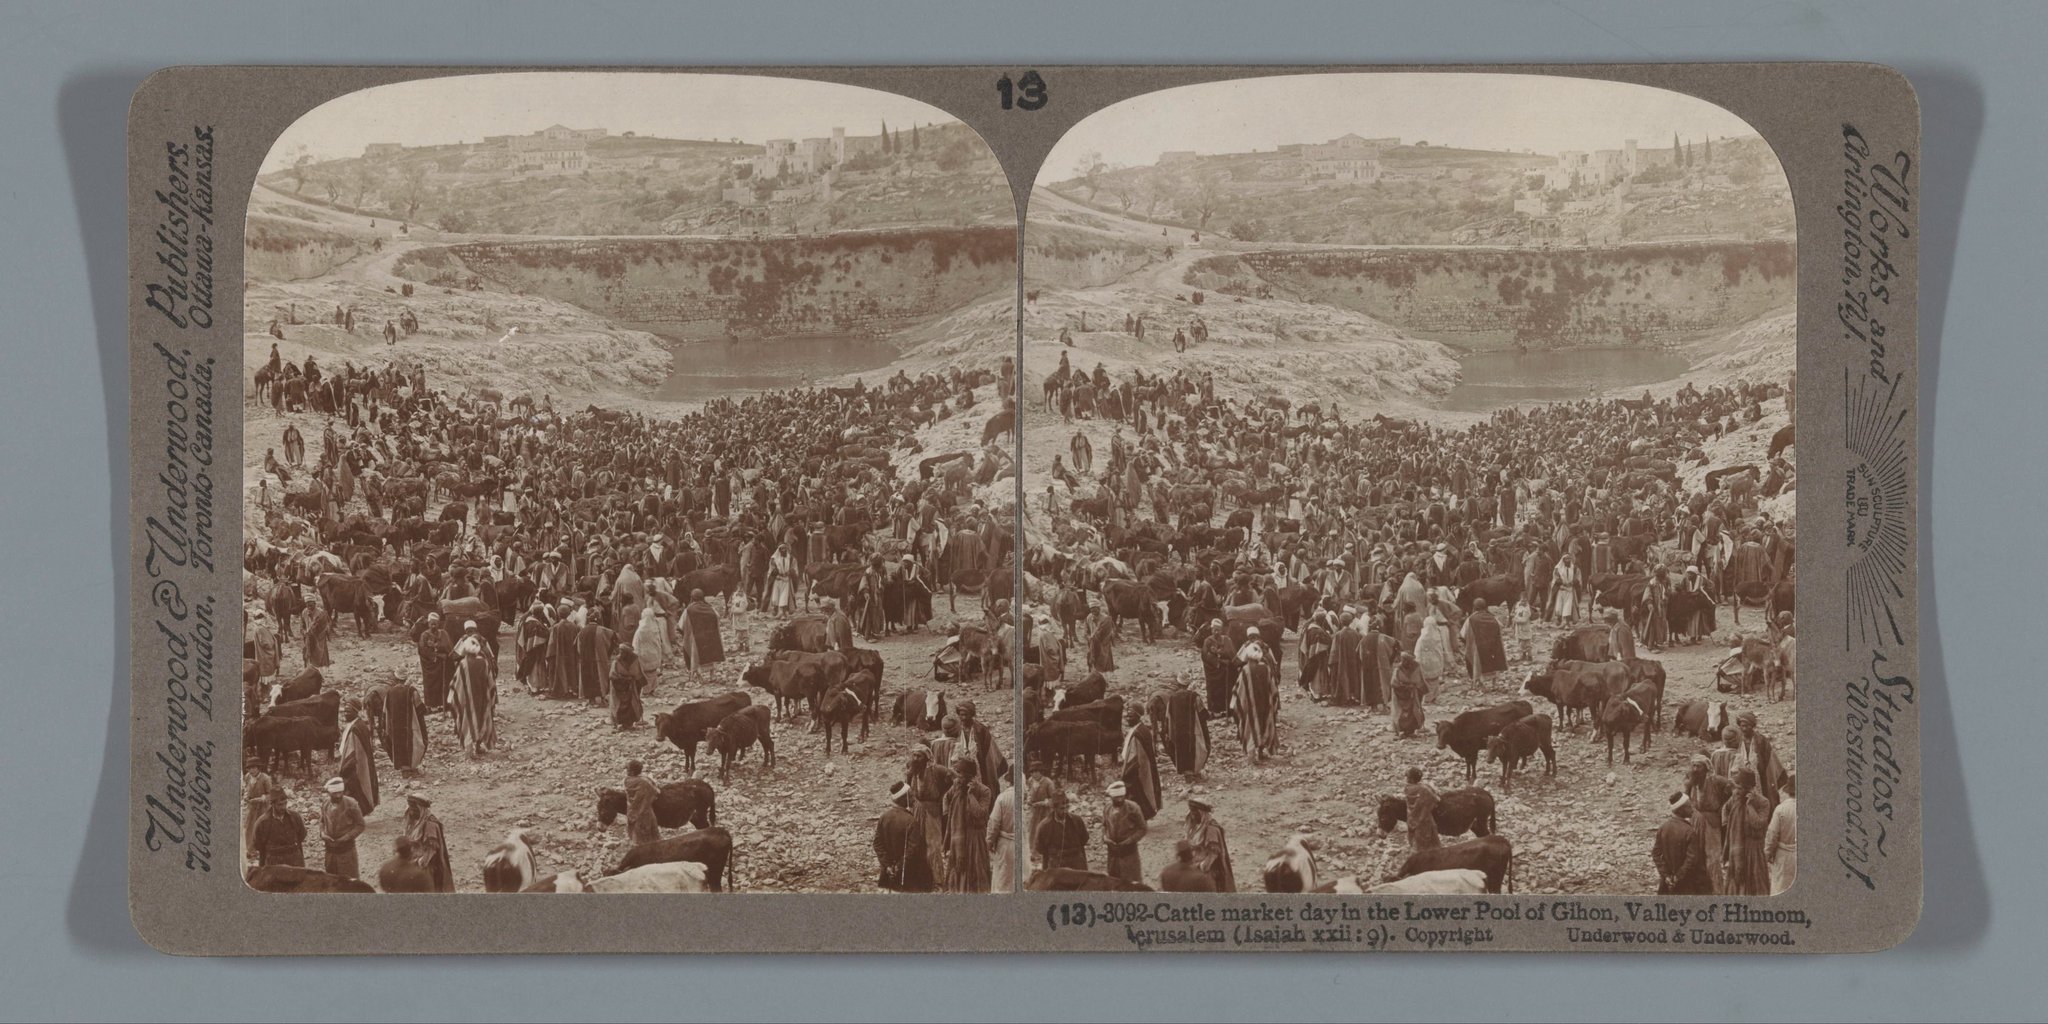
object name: stereograph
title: Cattle market day in the Lower Pool of Gihon, Valley of Hinnom, Jerusalem (Isaiah xxii:9)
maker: Anonymous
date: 1900-1905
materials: paper, cardboard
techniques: gelatin silver print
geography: dal van hinnom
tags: cattle, market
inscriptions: inscription, number: ‘13’, copyright notice: ‘Copyright Underwood & Underwood.’, number: ‘(13)-3092-’, inscription: ‘Works and Studios ~/ Arlington, N.J. Westwood, N.J.’